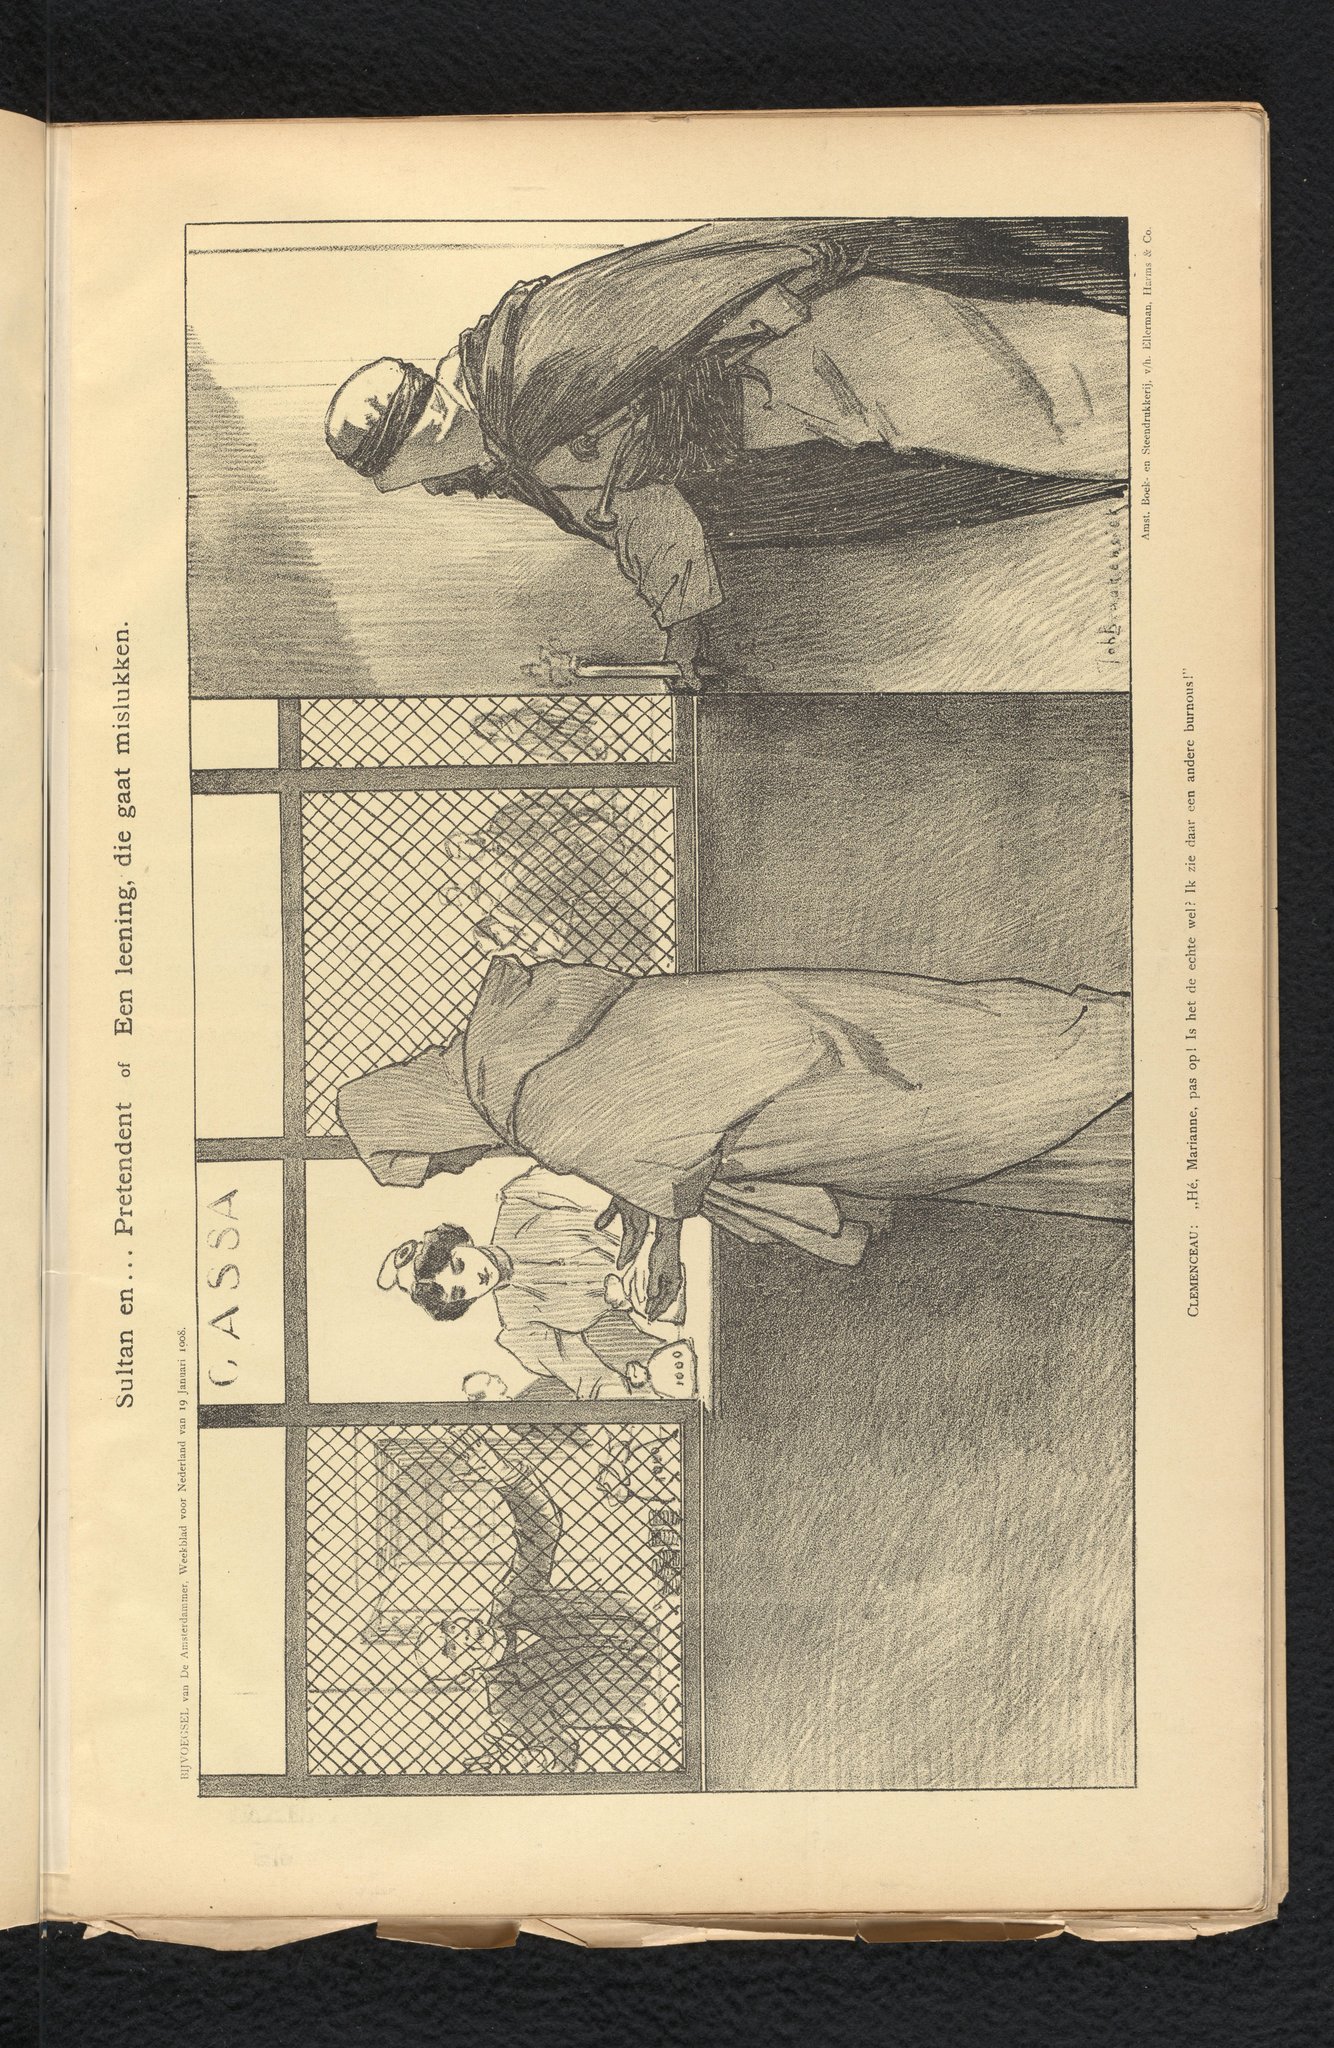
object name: cartoon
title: Sultan en ... Pretendent of Een leening, die gaat mislukken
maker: johan braakensiek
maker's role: draughtsman, print maker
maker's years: 1858-1940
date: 1908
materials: paper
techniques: lithograph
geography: amsterdam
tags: paris, personifications of countries, nations, states, districts, etc., banker, bank, political caricatures and satires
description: De Franse premier Georges Clemenceau als bankier maant Marianne (Frankrijk) bij het loket tot voorzichtigheid bij het verlenen van een financiële lening aan de sultan Abd el Aziz van Marokko omdat ook een ander de bank binnenkomt voor de lening, waarschijnlijk pretendent Abdelhafid.